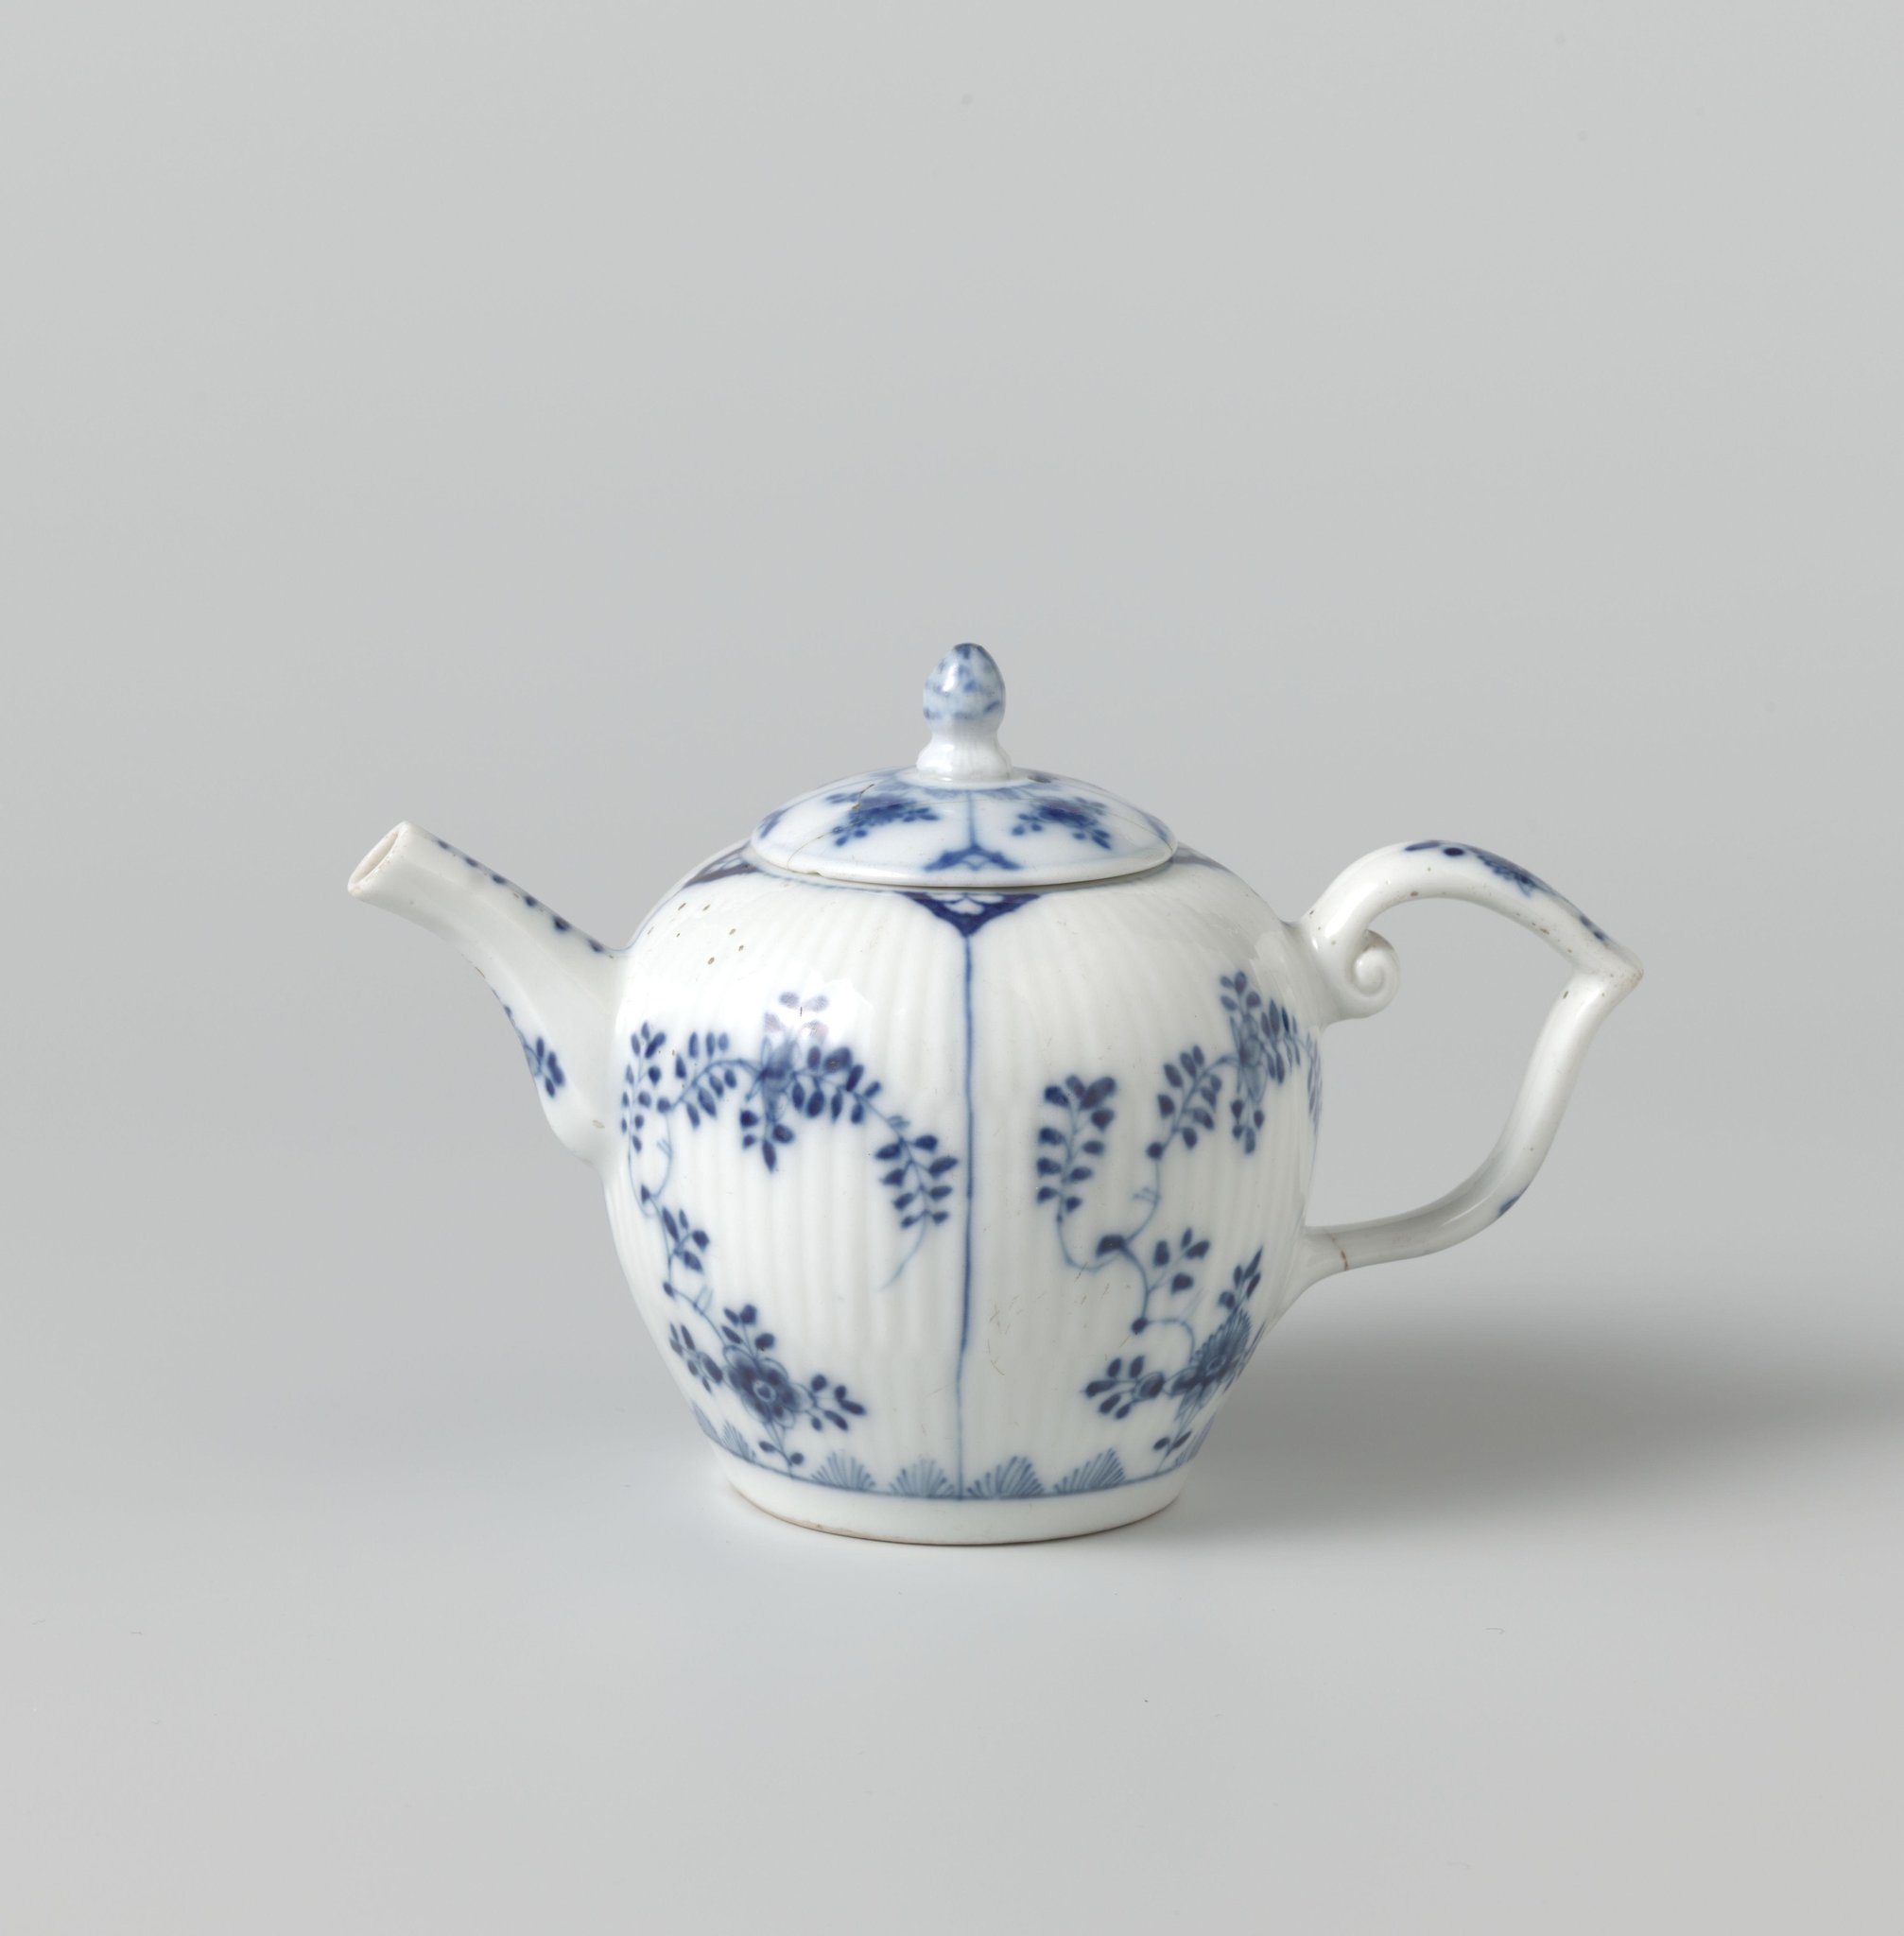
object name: teapot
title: Theepot, beschilderd in onderglazuurblauw met bladertakken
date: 1750-1760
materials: porcelain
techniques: painted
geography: meissen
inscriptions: mark: ‘V’, factory mark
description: Theepot van beschilderd porselein. De pot heeft een S-vormig oor en een achthoekige tuit. Het lichaam is versierd met drie rijen verspringende ribben in reliëf. De beschildering bestaat uit het Zwiebelmuster binnen vier vakken in onderglazuurblauw. Het niet bijbehorende deksel heeft dezelfde beschildering. De theepot is gemerkt.